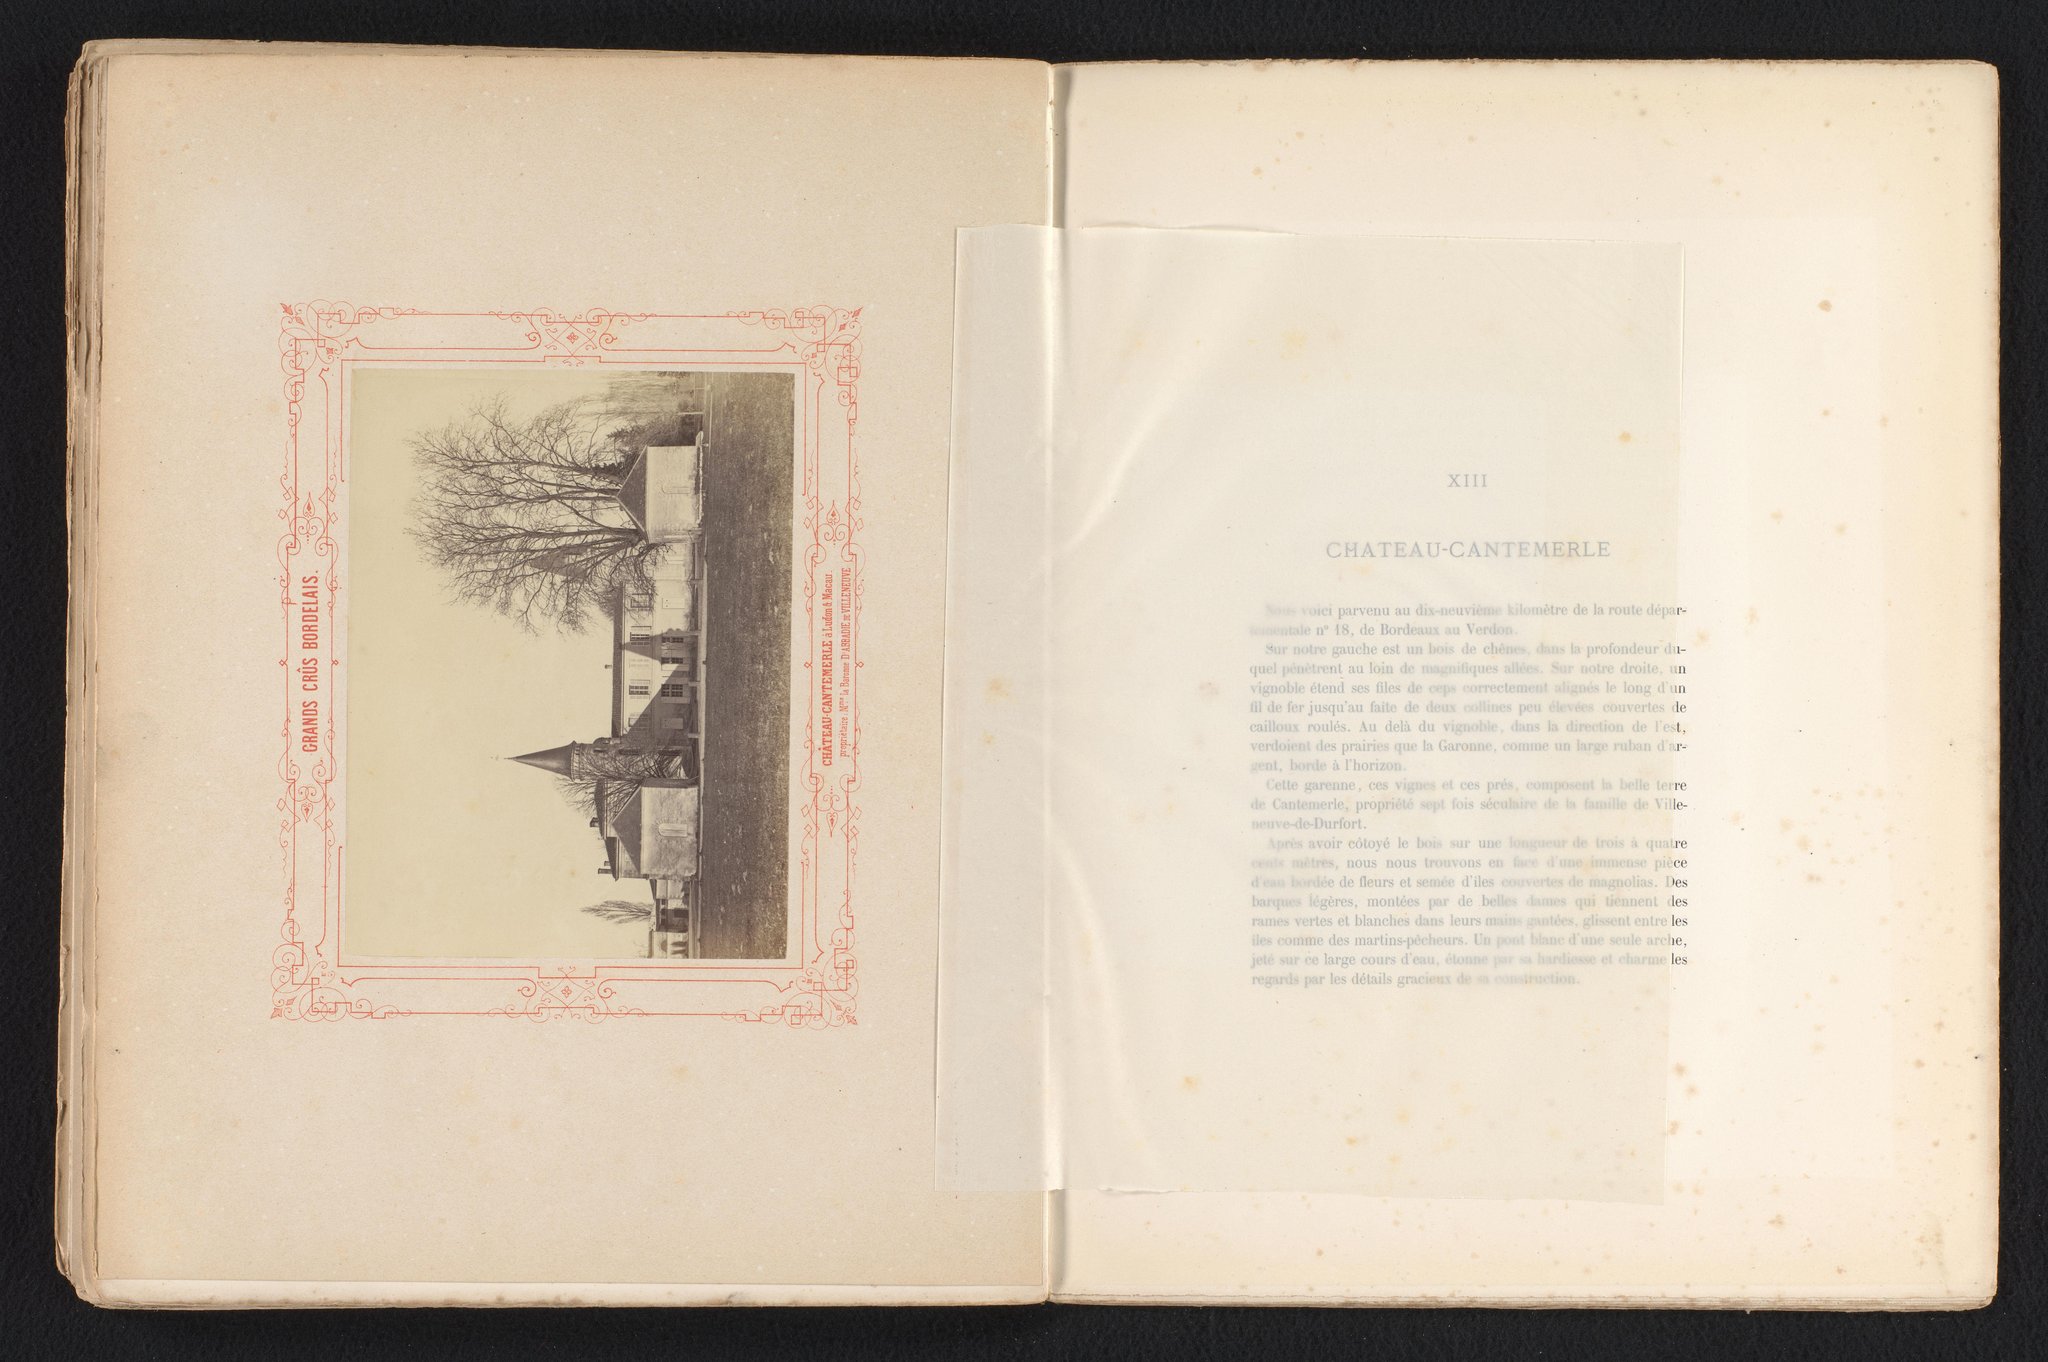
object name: photograph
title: Gezicht op Château Cantemerle in Macau, Frankrijk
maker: alfred danflou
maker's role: fotograaf, schrijver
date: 1862-1867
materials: paper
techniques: albumen print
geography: macau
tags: castle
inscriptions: inscription: ‘propriétaire: Mme. la Baronne D'ABBADIE de VILLENEUVE’